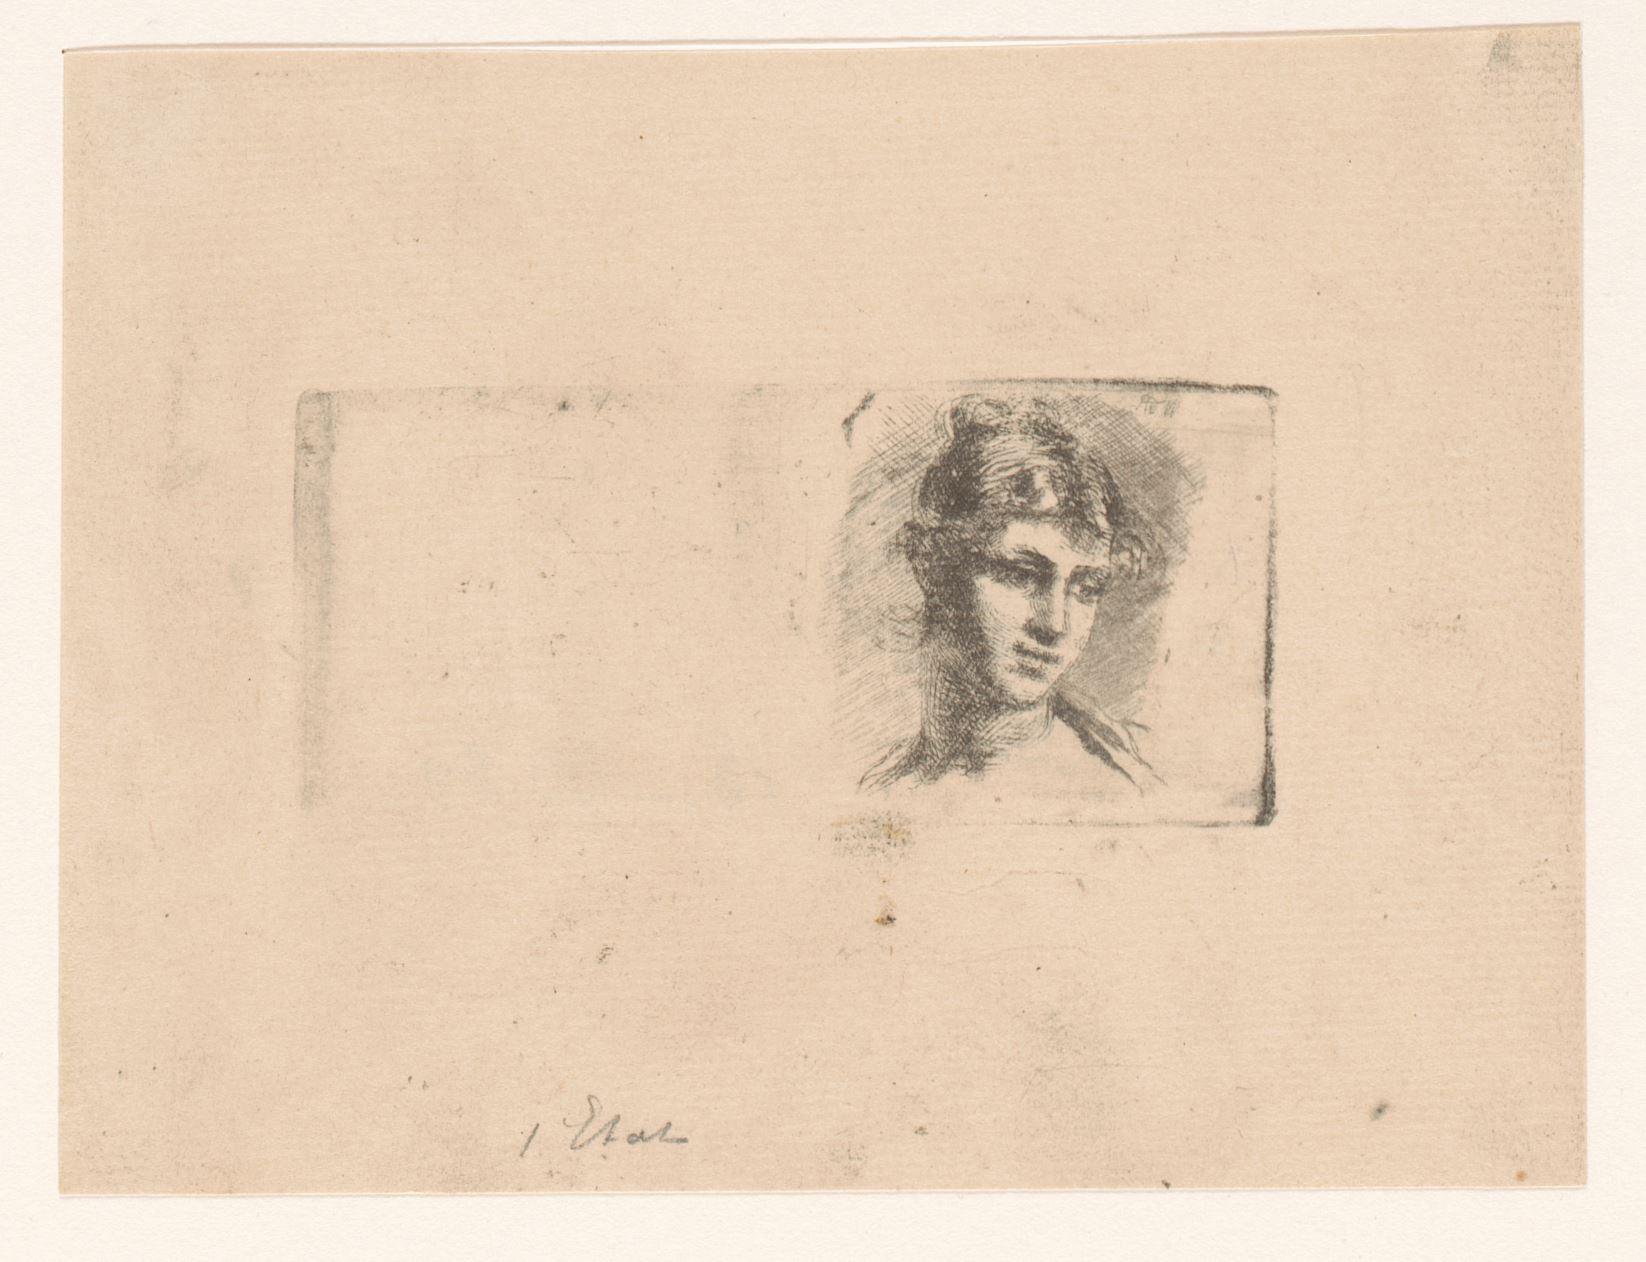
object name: print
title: Hoofd van een jonge vrouw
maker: adrien de witte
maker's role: print maker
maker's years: 1850-1935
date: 1860-1913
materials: paper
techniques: etching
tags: adolescent, young woman, maiden, head (human) - aa - female human figure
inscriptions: collector's mark: Lugt 2228